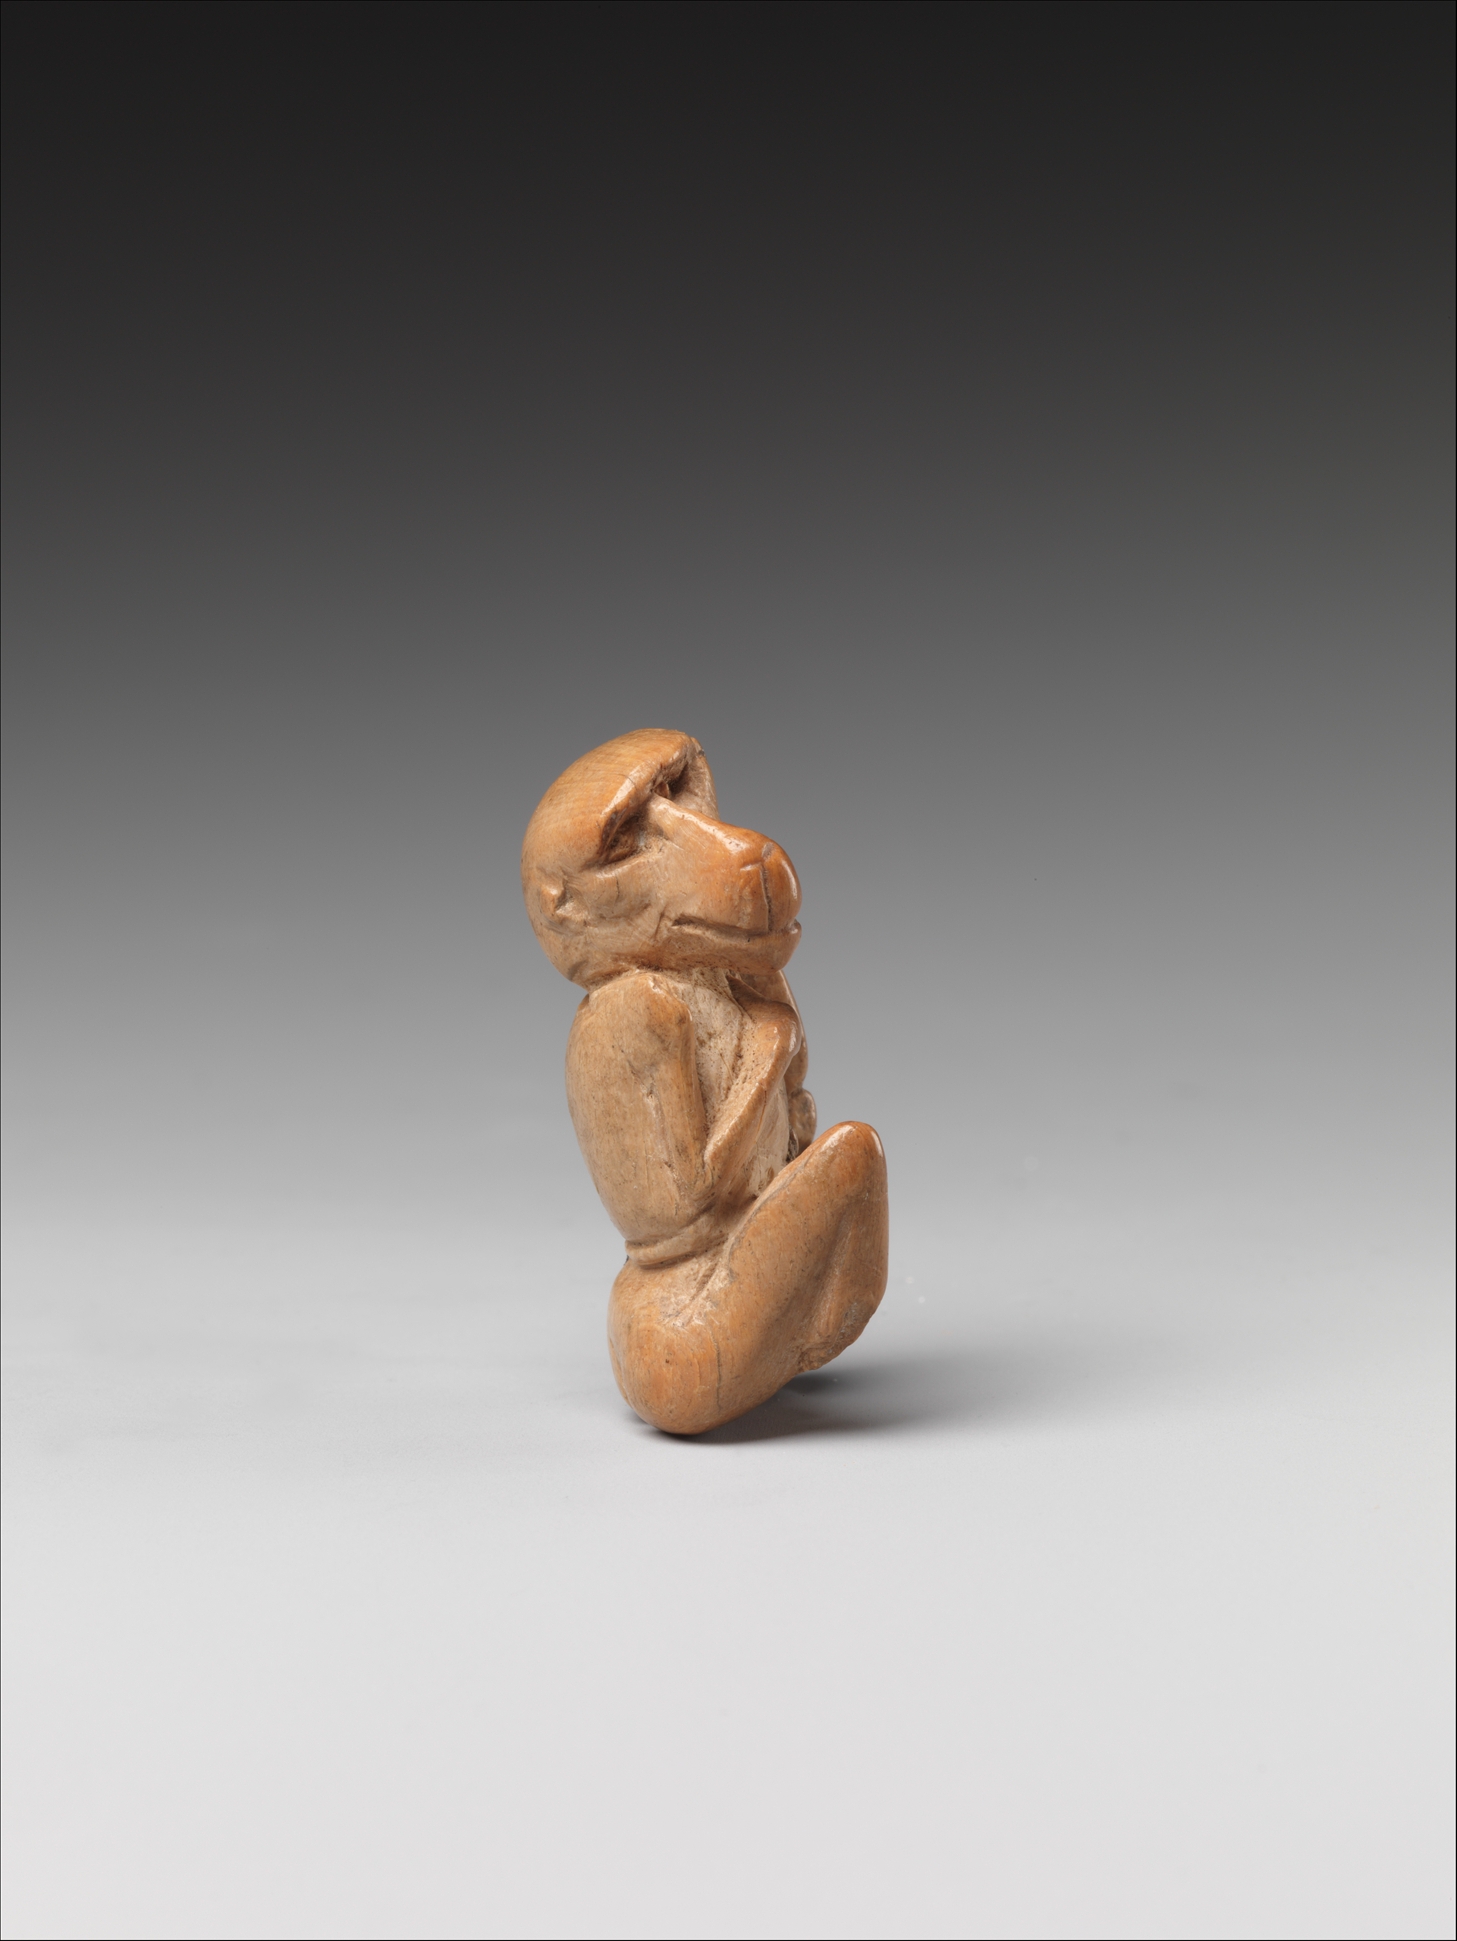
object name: game piece, baboon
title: Game piece in the shape of a baboon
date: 332-330 BCE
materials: bone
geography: egypt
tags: games,baboons